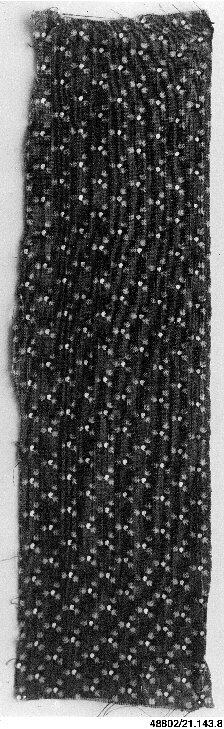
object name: textile fragment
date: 1801-1900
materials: cotton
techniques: printing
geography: india